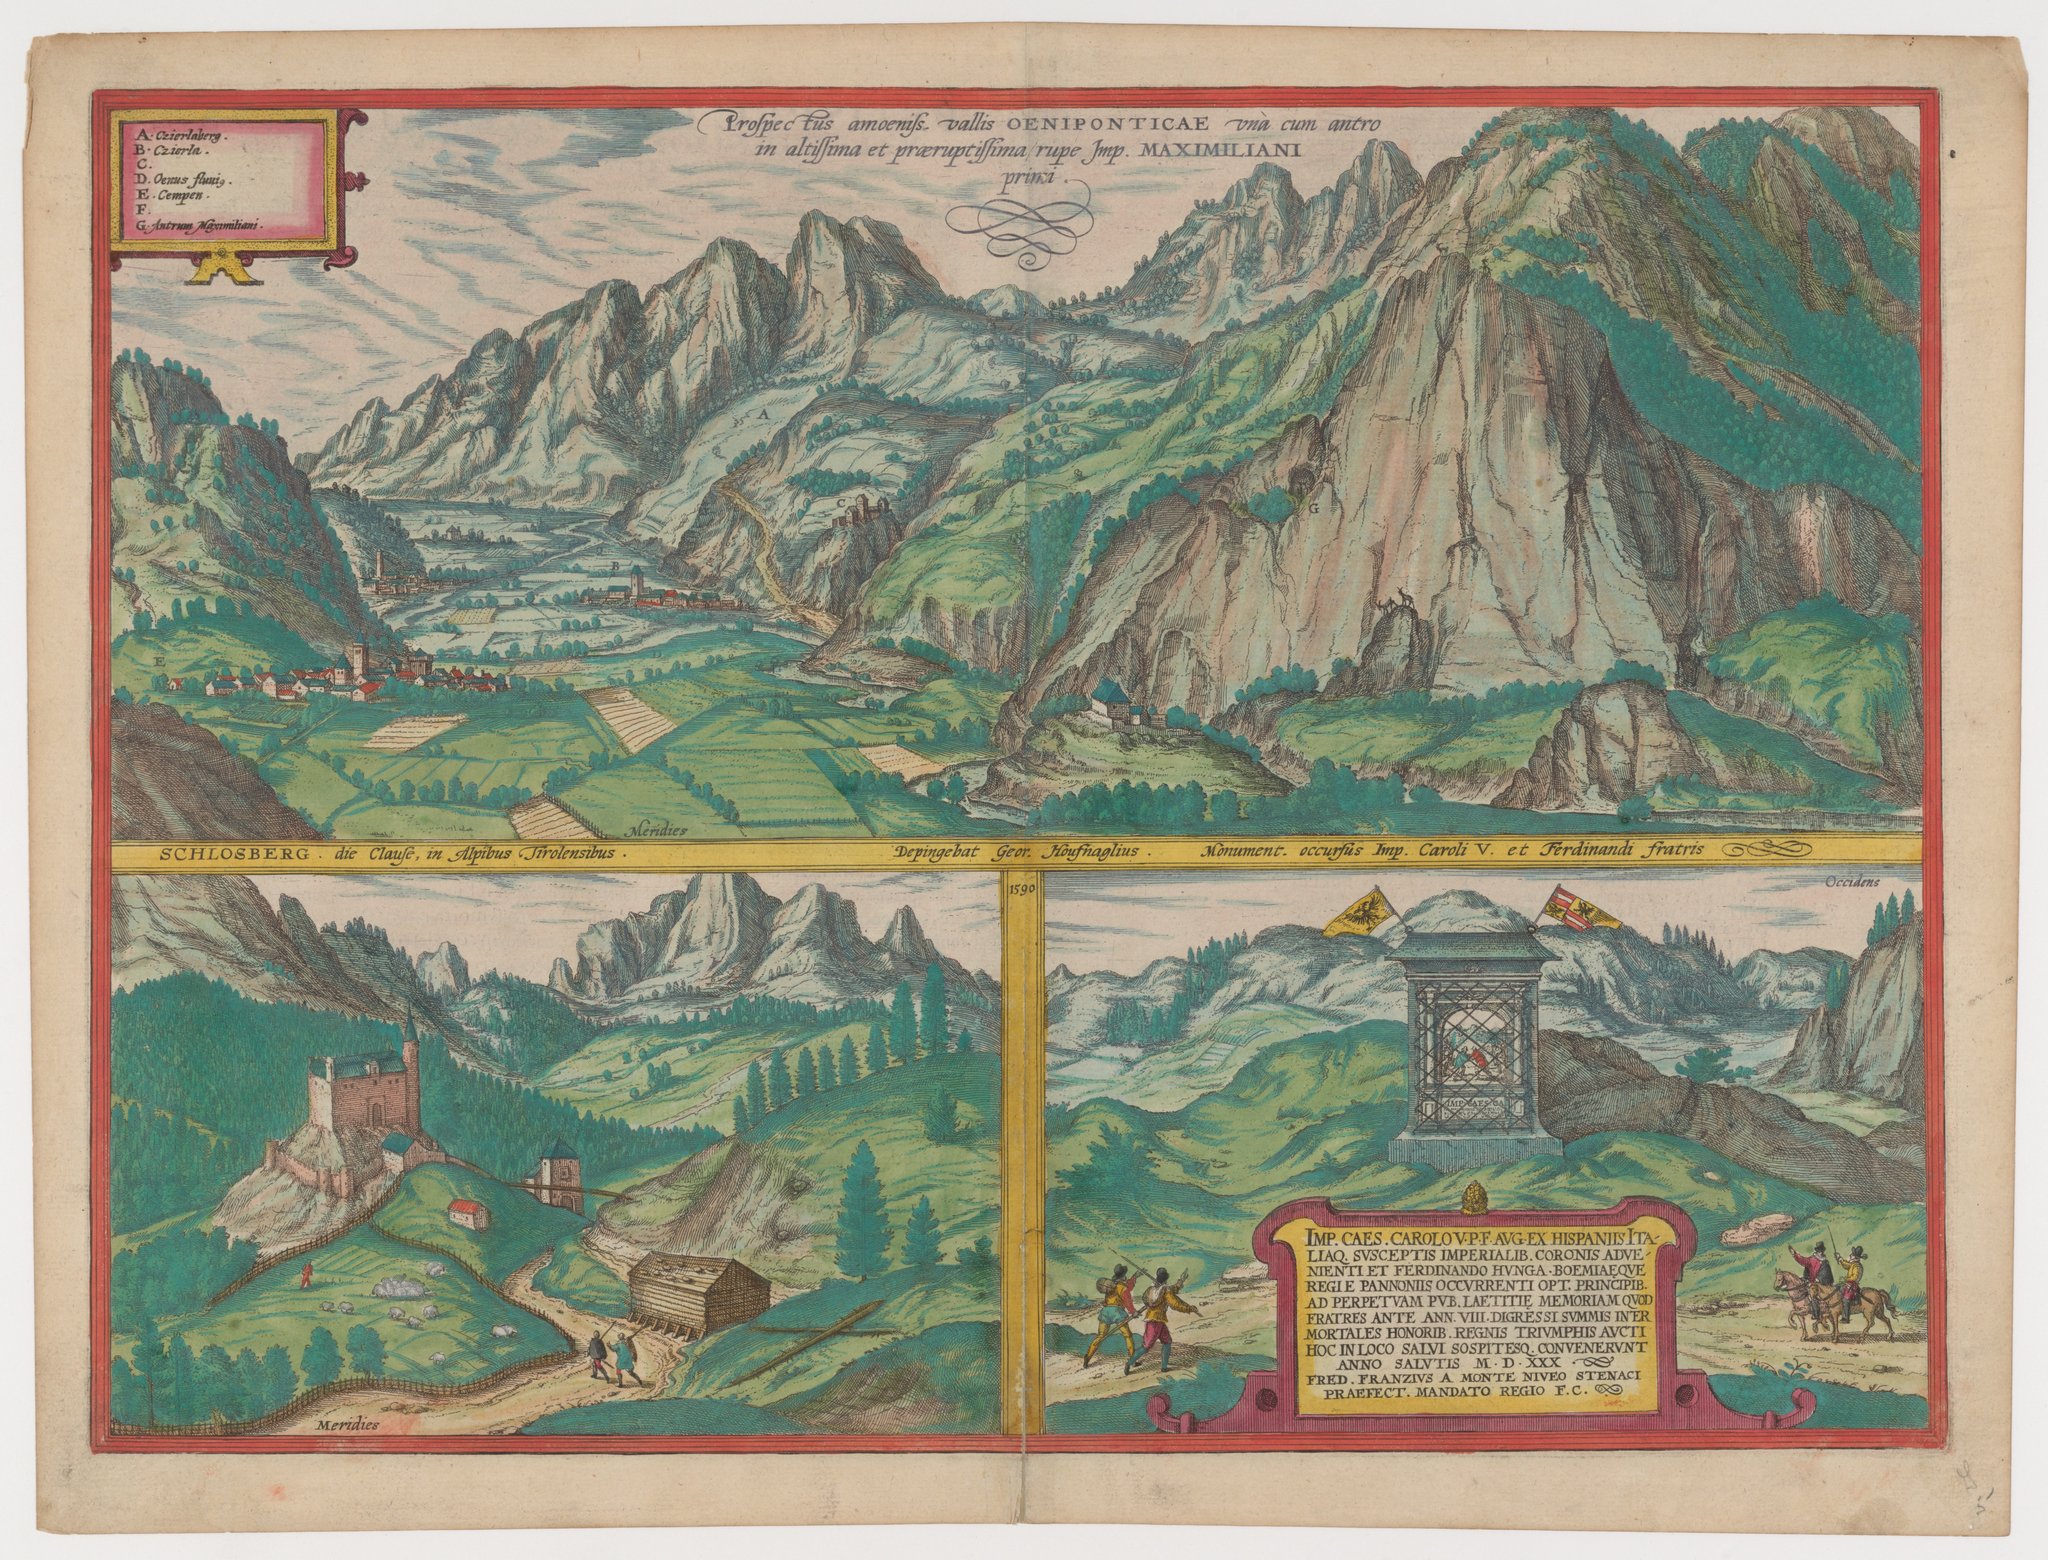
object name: print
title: The Inn Valley from the series Civitates Orbis Terrarum, vol. V, plate 59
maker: simon novellanus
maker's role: artist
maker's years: 16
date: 1590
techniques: etching, hand coloring